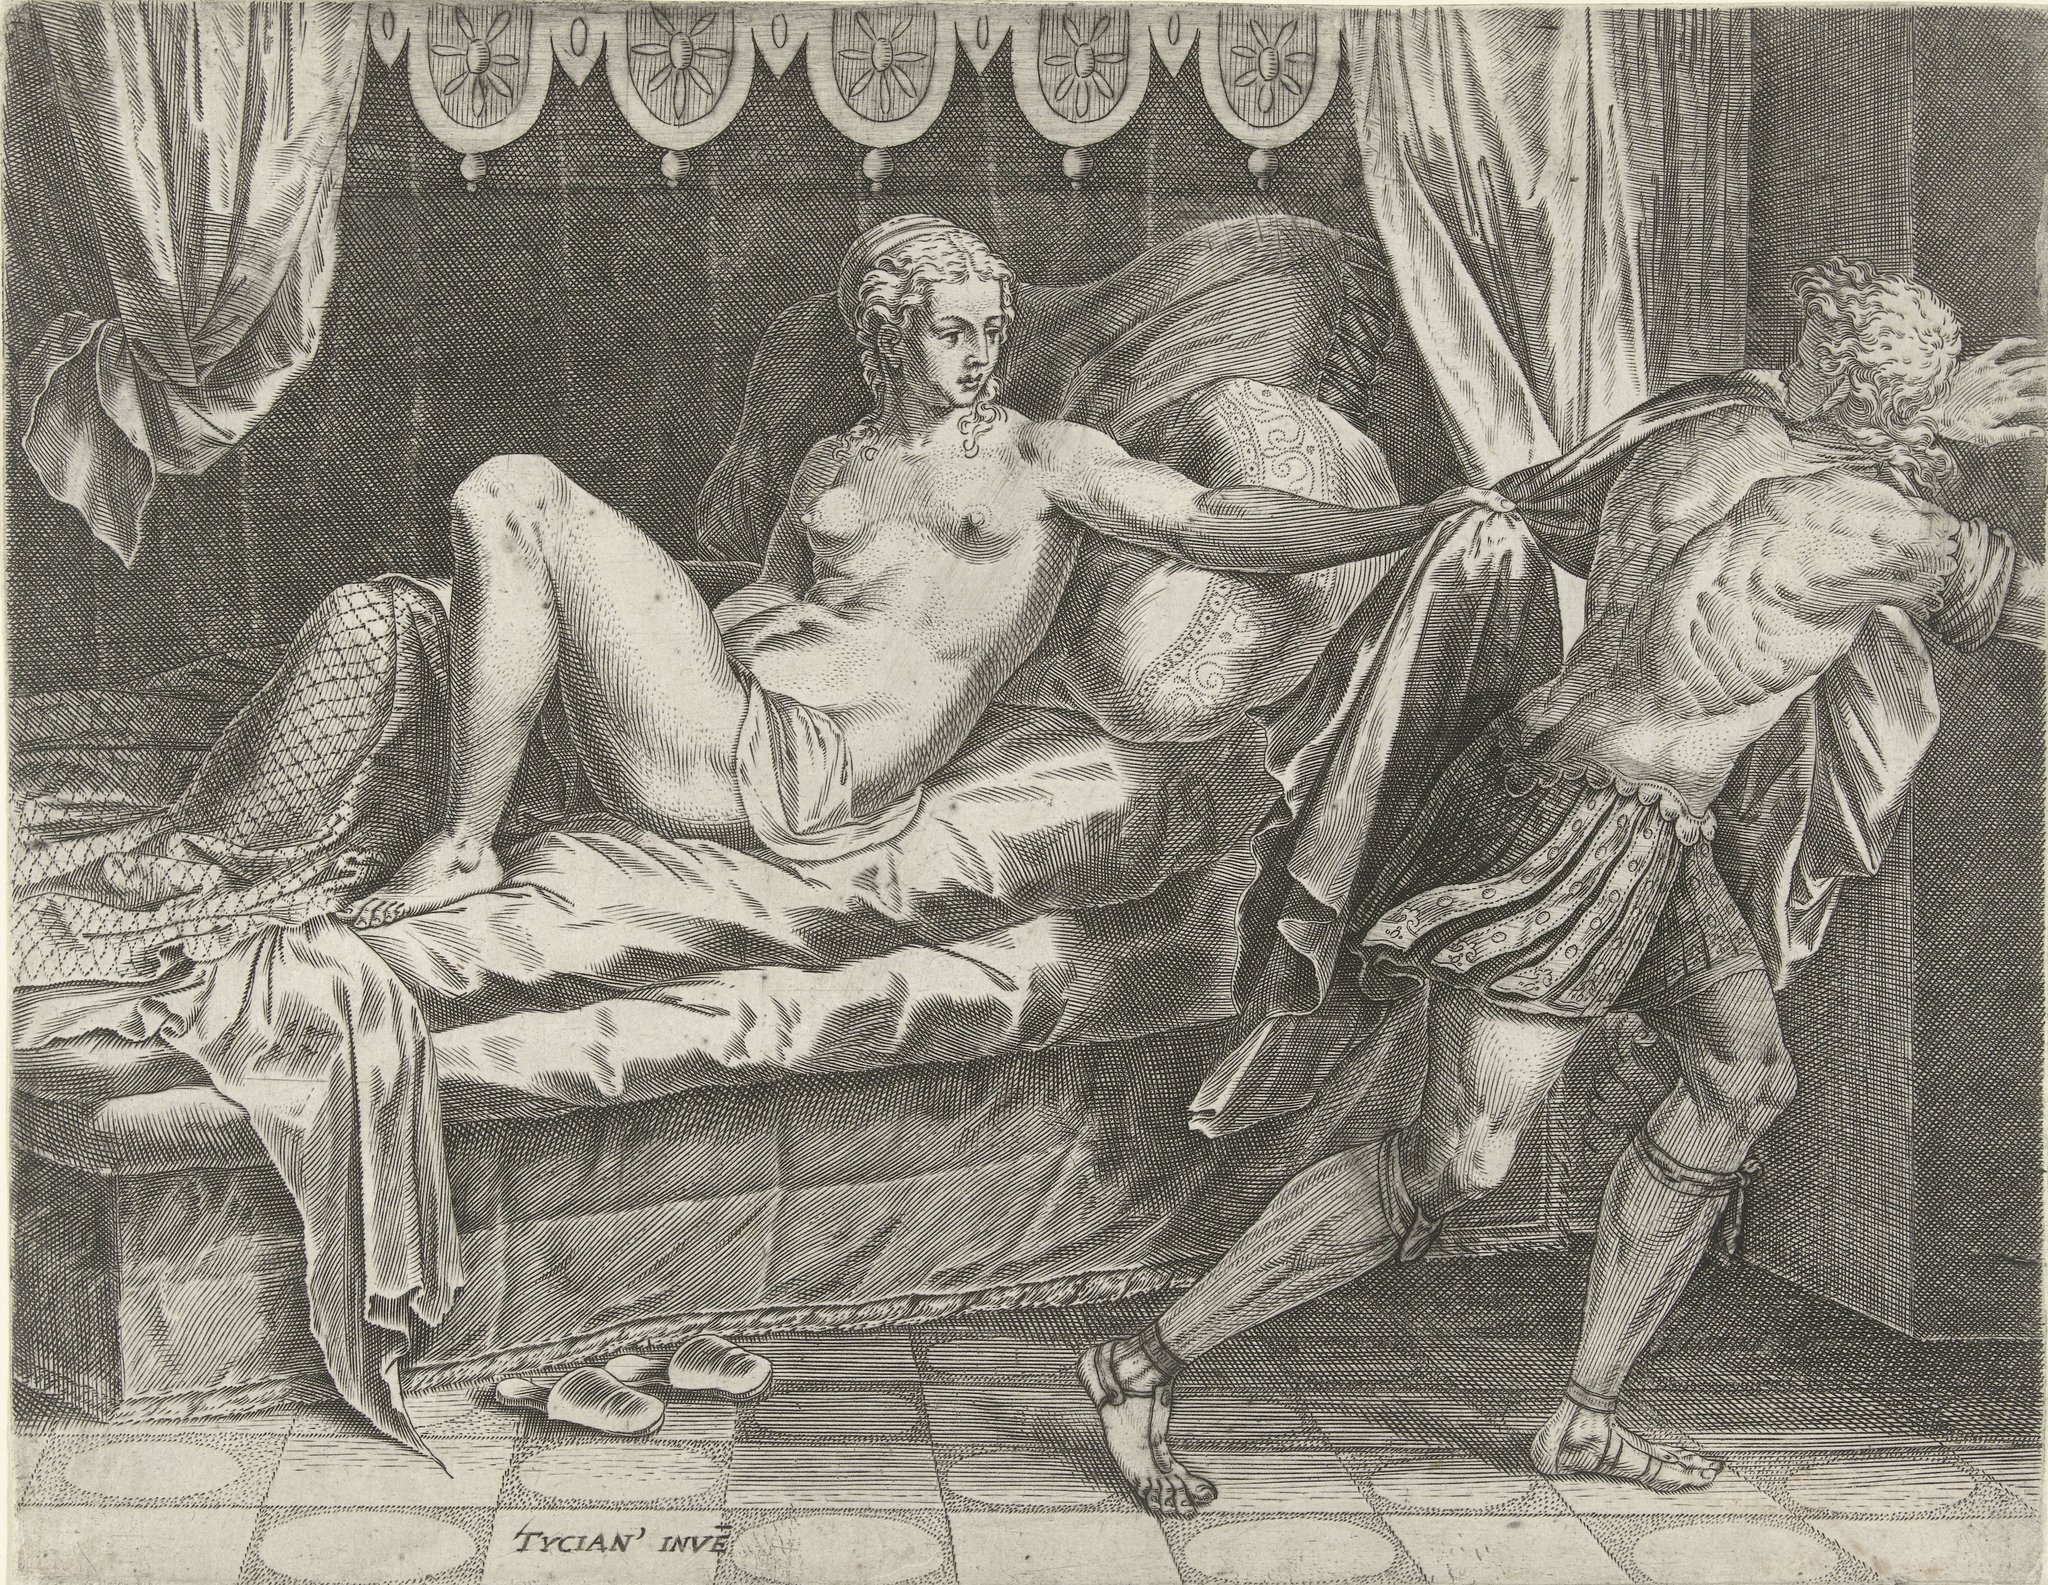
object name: print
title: Jozef en de vrouw van Potifar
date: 1560-1565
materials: paper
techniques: engraving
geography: venice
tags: potiphar's wife catches joseph by his robe, usually while lying in bed; joseph escapes leaving his cloak behind in her hands (possibly with a naked child lying in a crib), bed with tester, slippers, cape (+ men's clothes)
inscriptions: signature: ‘TYCIAN INVE[NIT]’, collector's mark: Lugt 240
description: De vrouw van Potifar ligt naakt op een hemelbed. Jozef vlucht van haar weg (naar rechts) en wordt door haar aan zijn mantel vastgehouden.